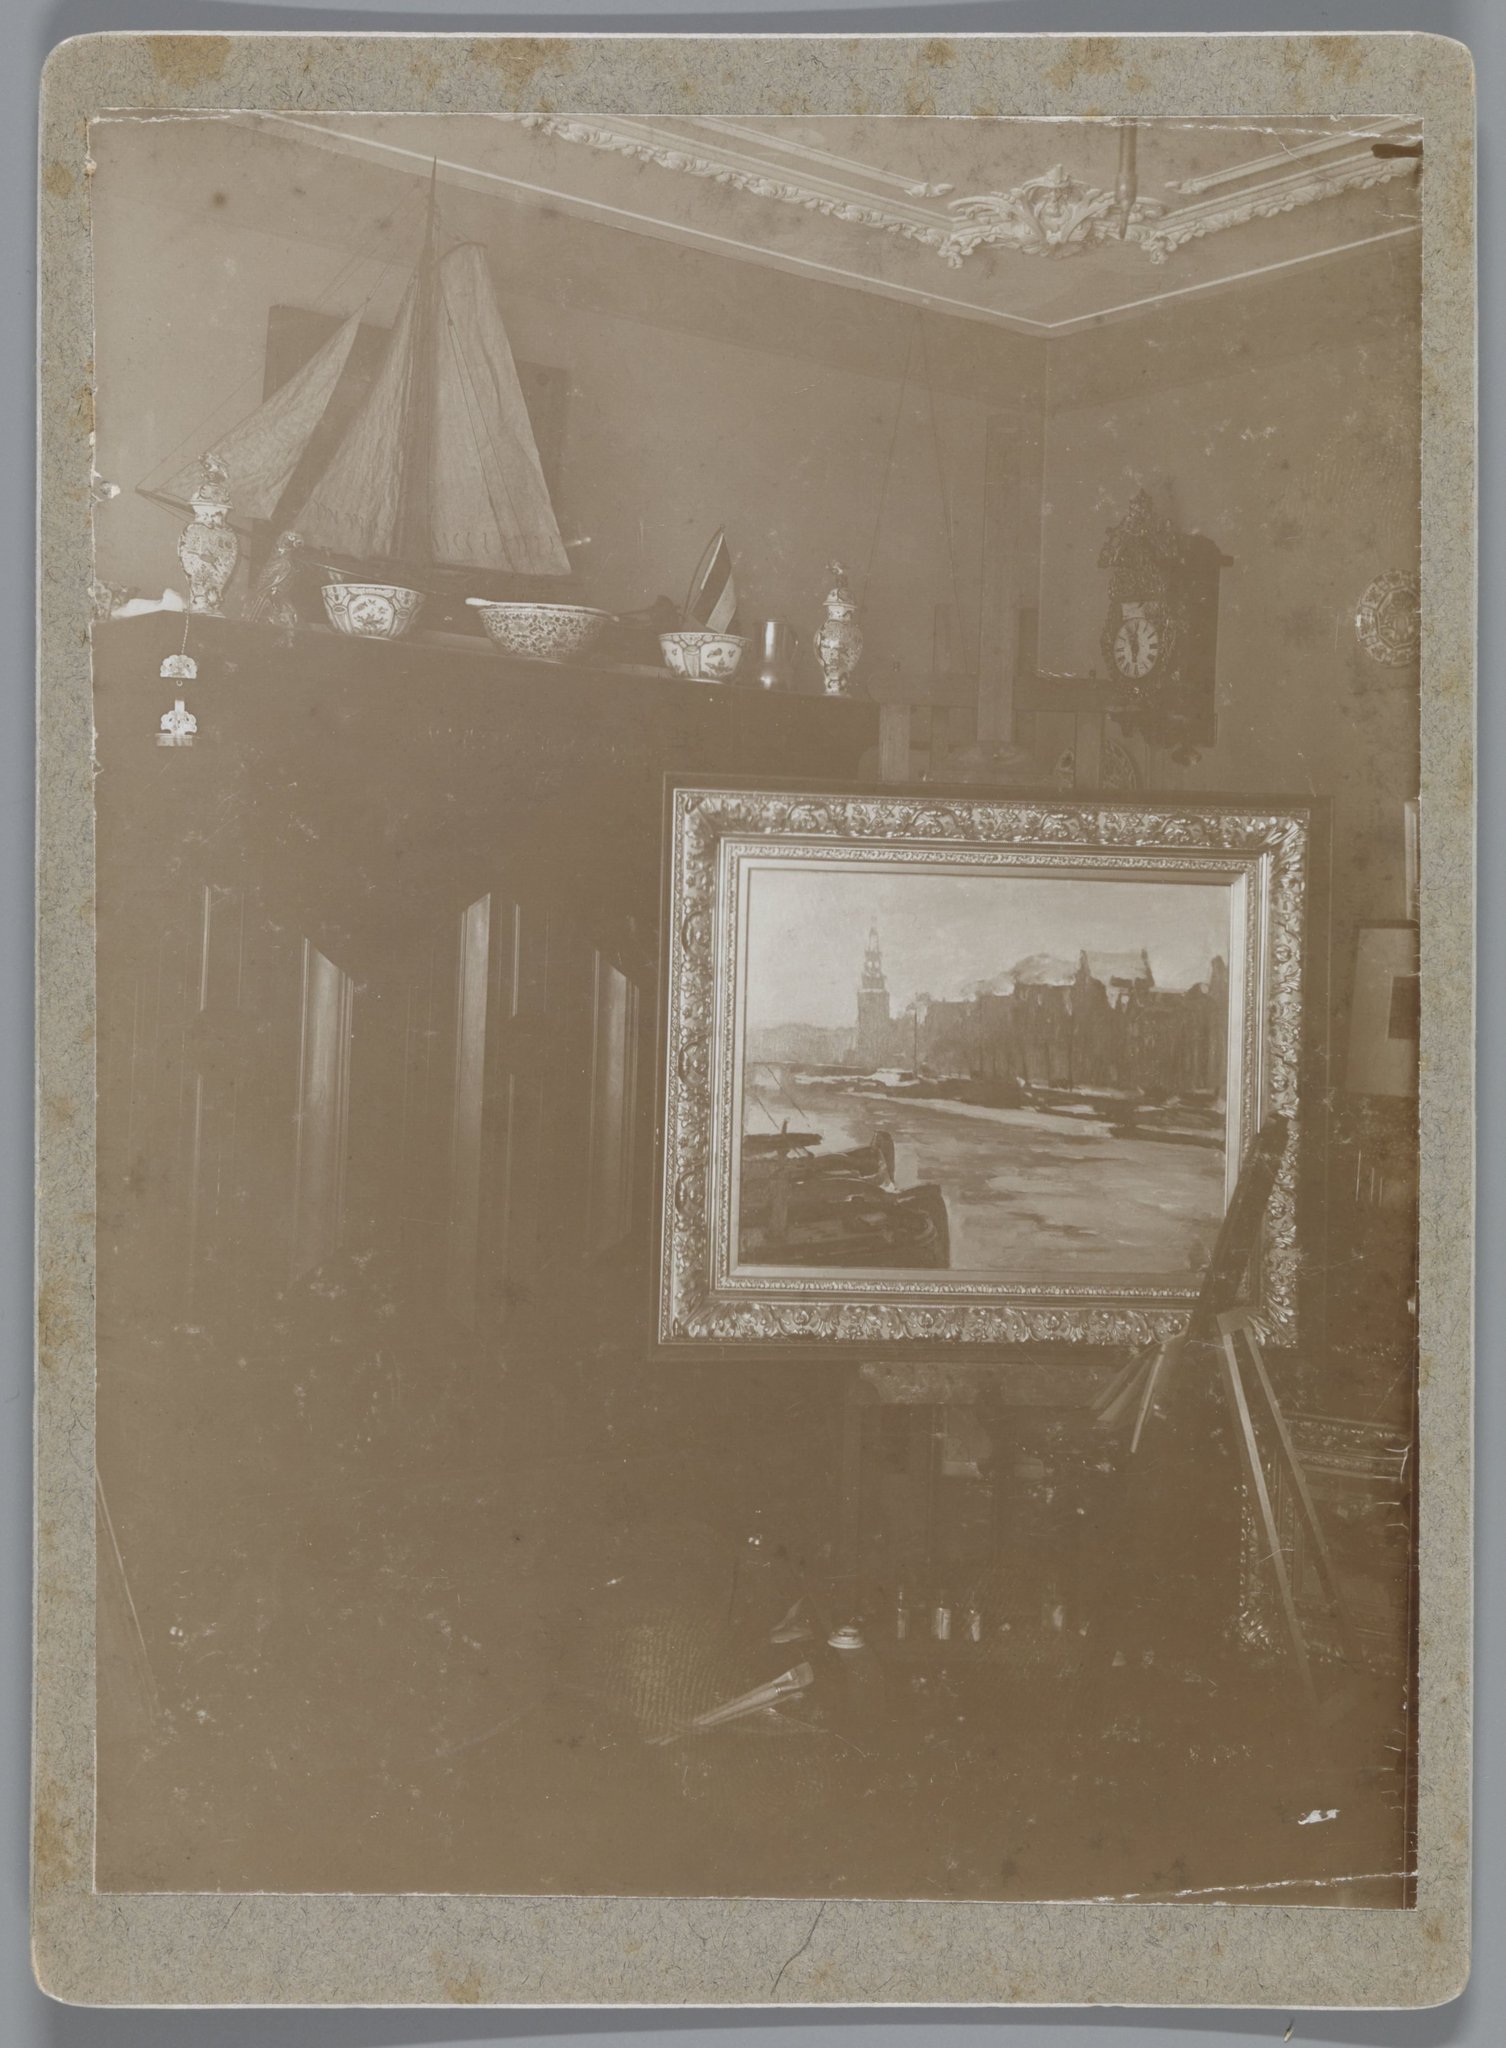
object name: photograph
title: Interieur Witsen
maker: willem witsen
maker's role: draughtsman, painter, print maker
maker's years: 1860-1923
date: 1860-1915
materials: cardboard, paper, photographic support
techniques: collodion silver print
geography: amsterdam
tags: witsenhuis